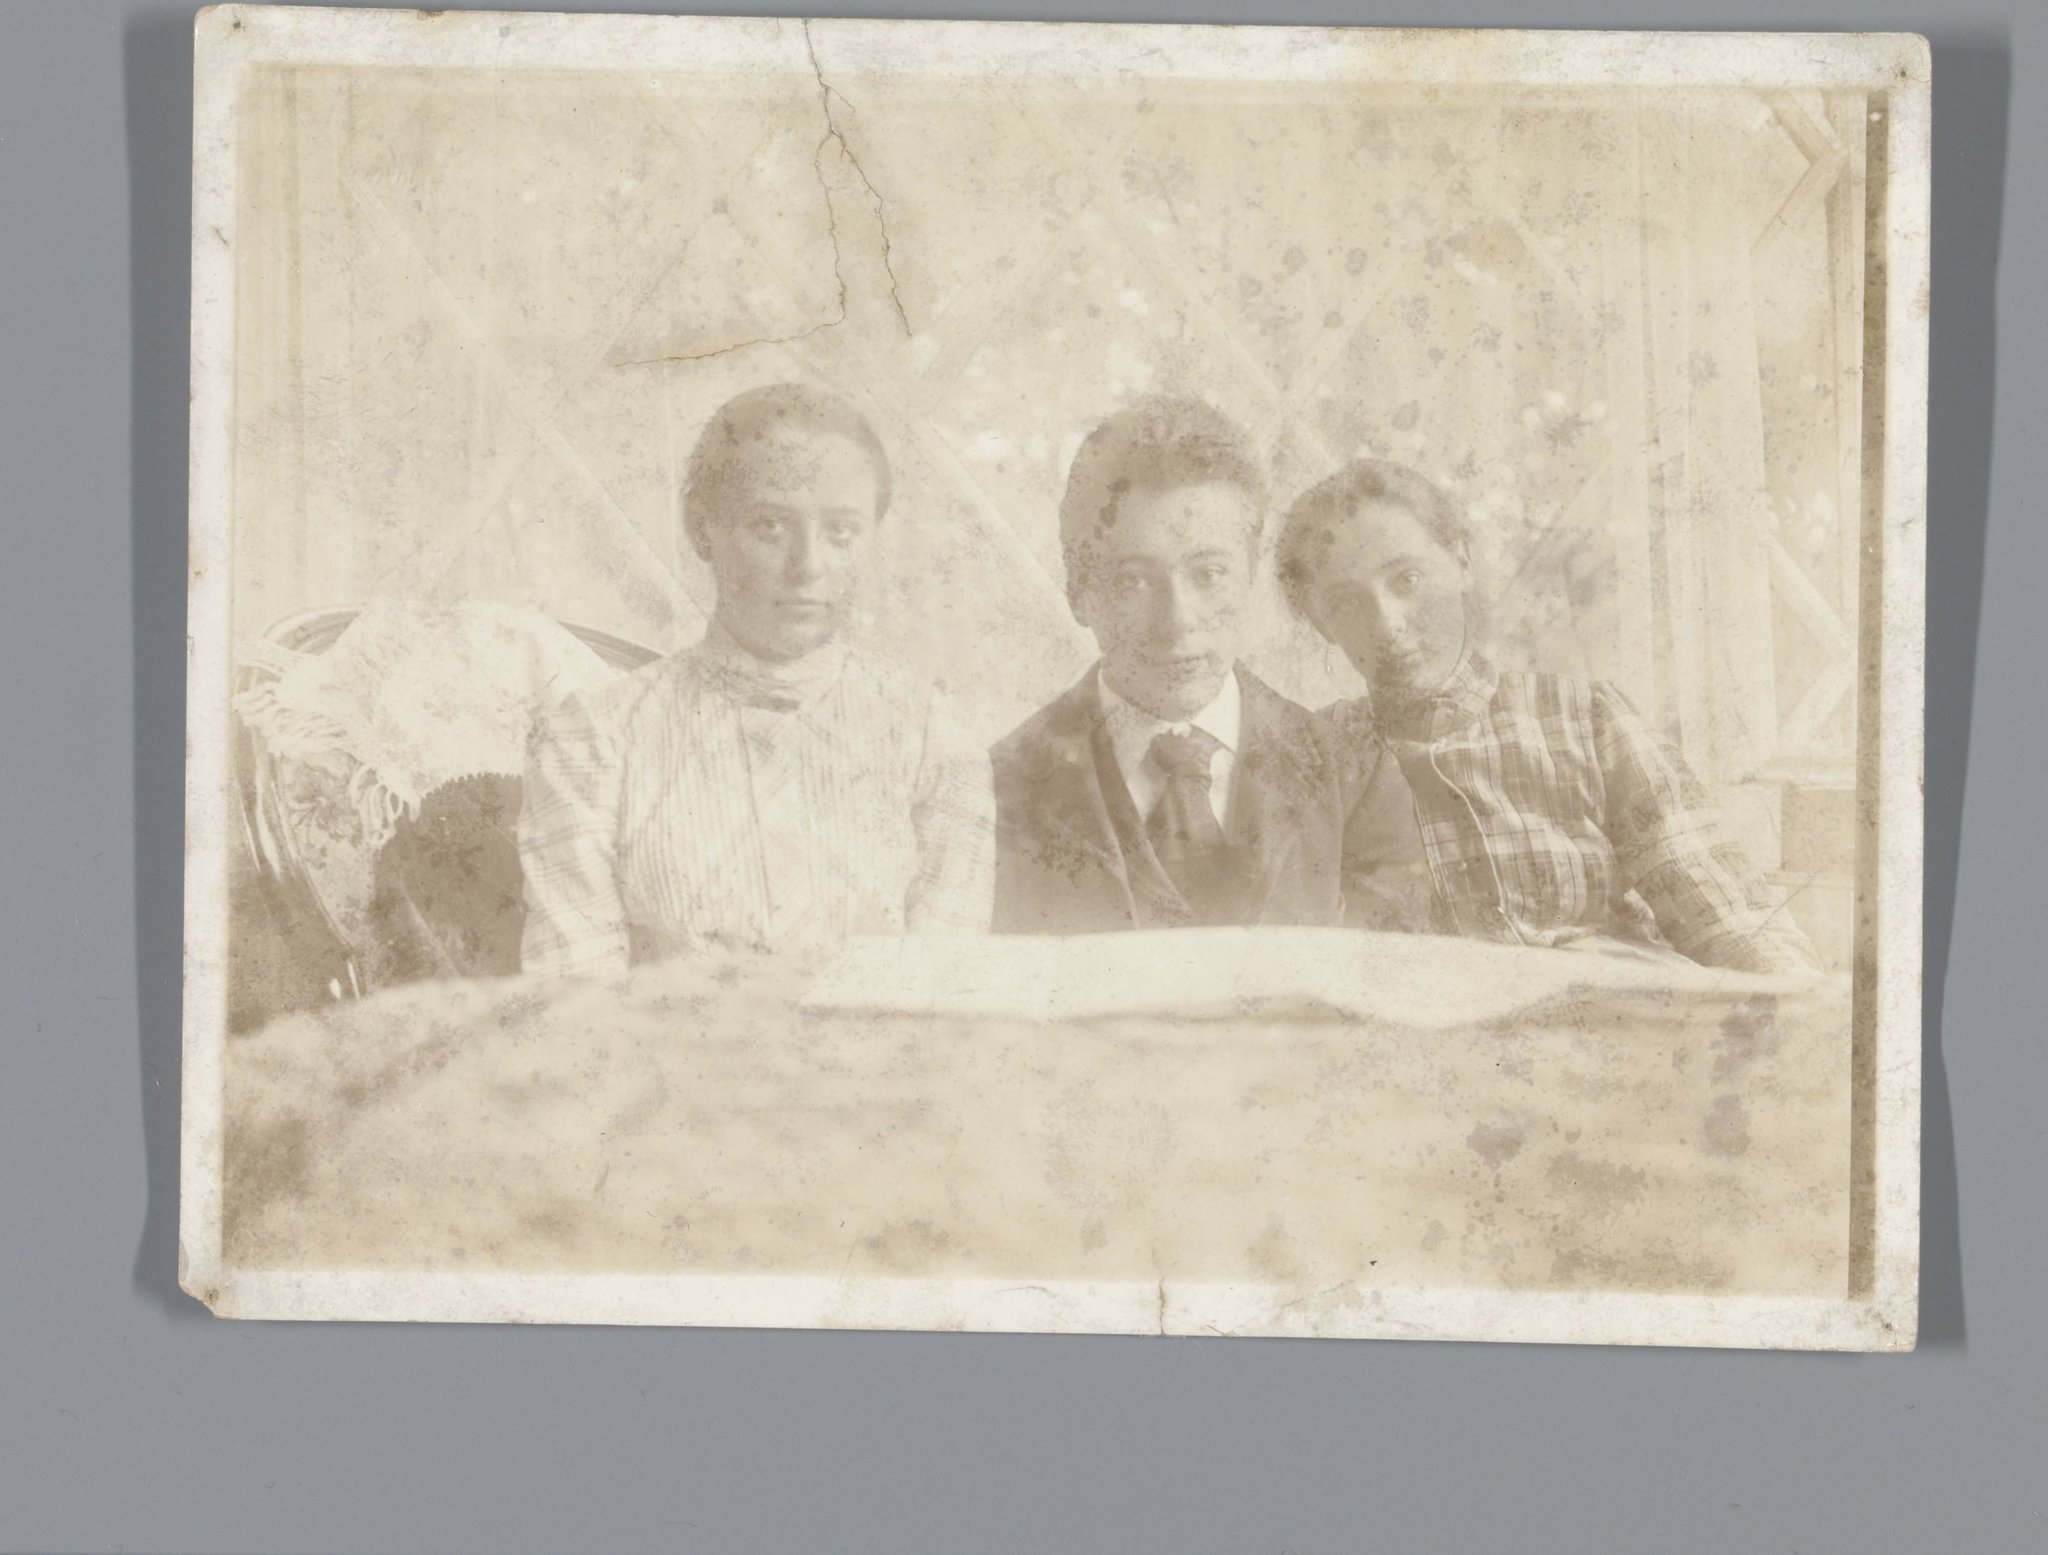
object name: photograph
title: Drieling Arntzenius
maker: willem witsen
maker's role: draughtsman, painter, print maker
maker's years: 1860-1923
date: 1860-1915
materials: paper, photographic support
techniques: gelatin silver print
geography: amsterdam